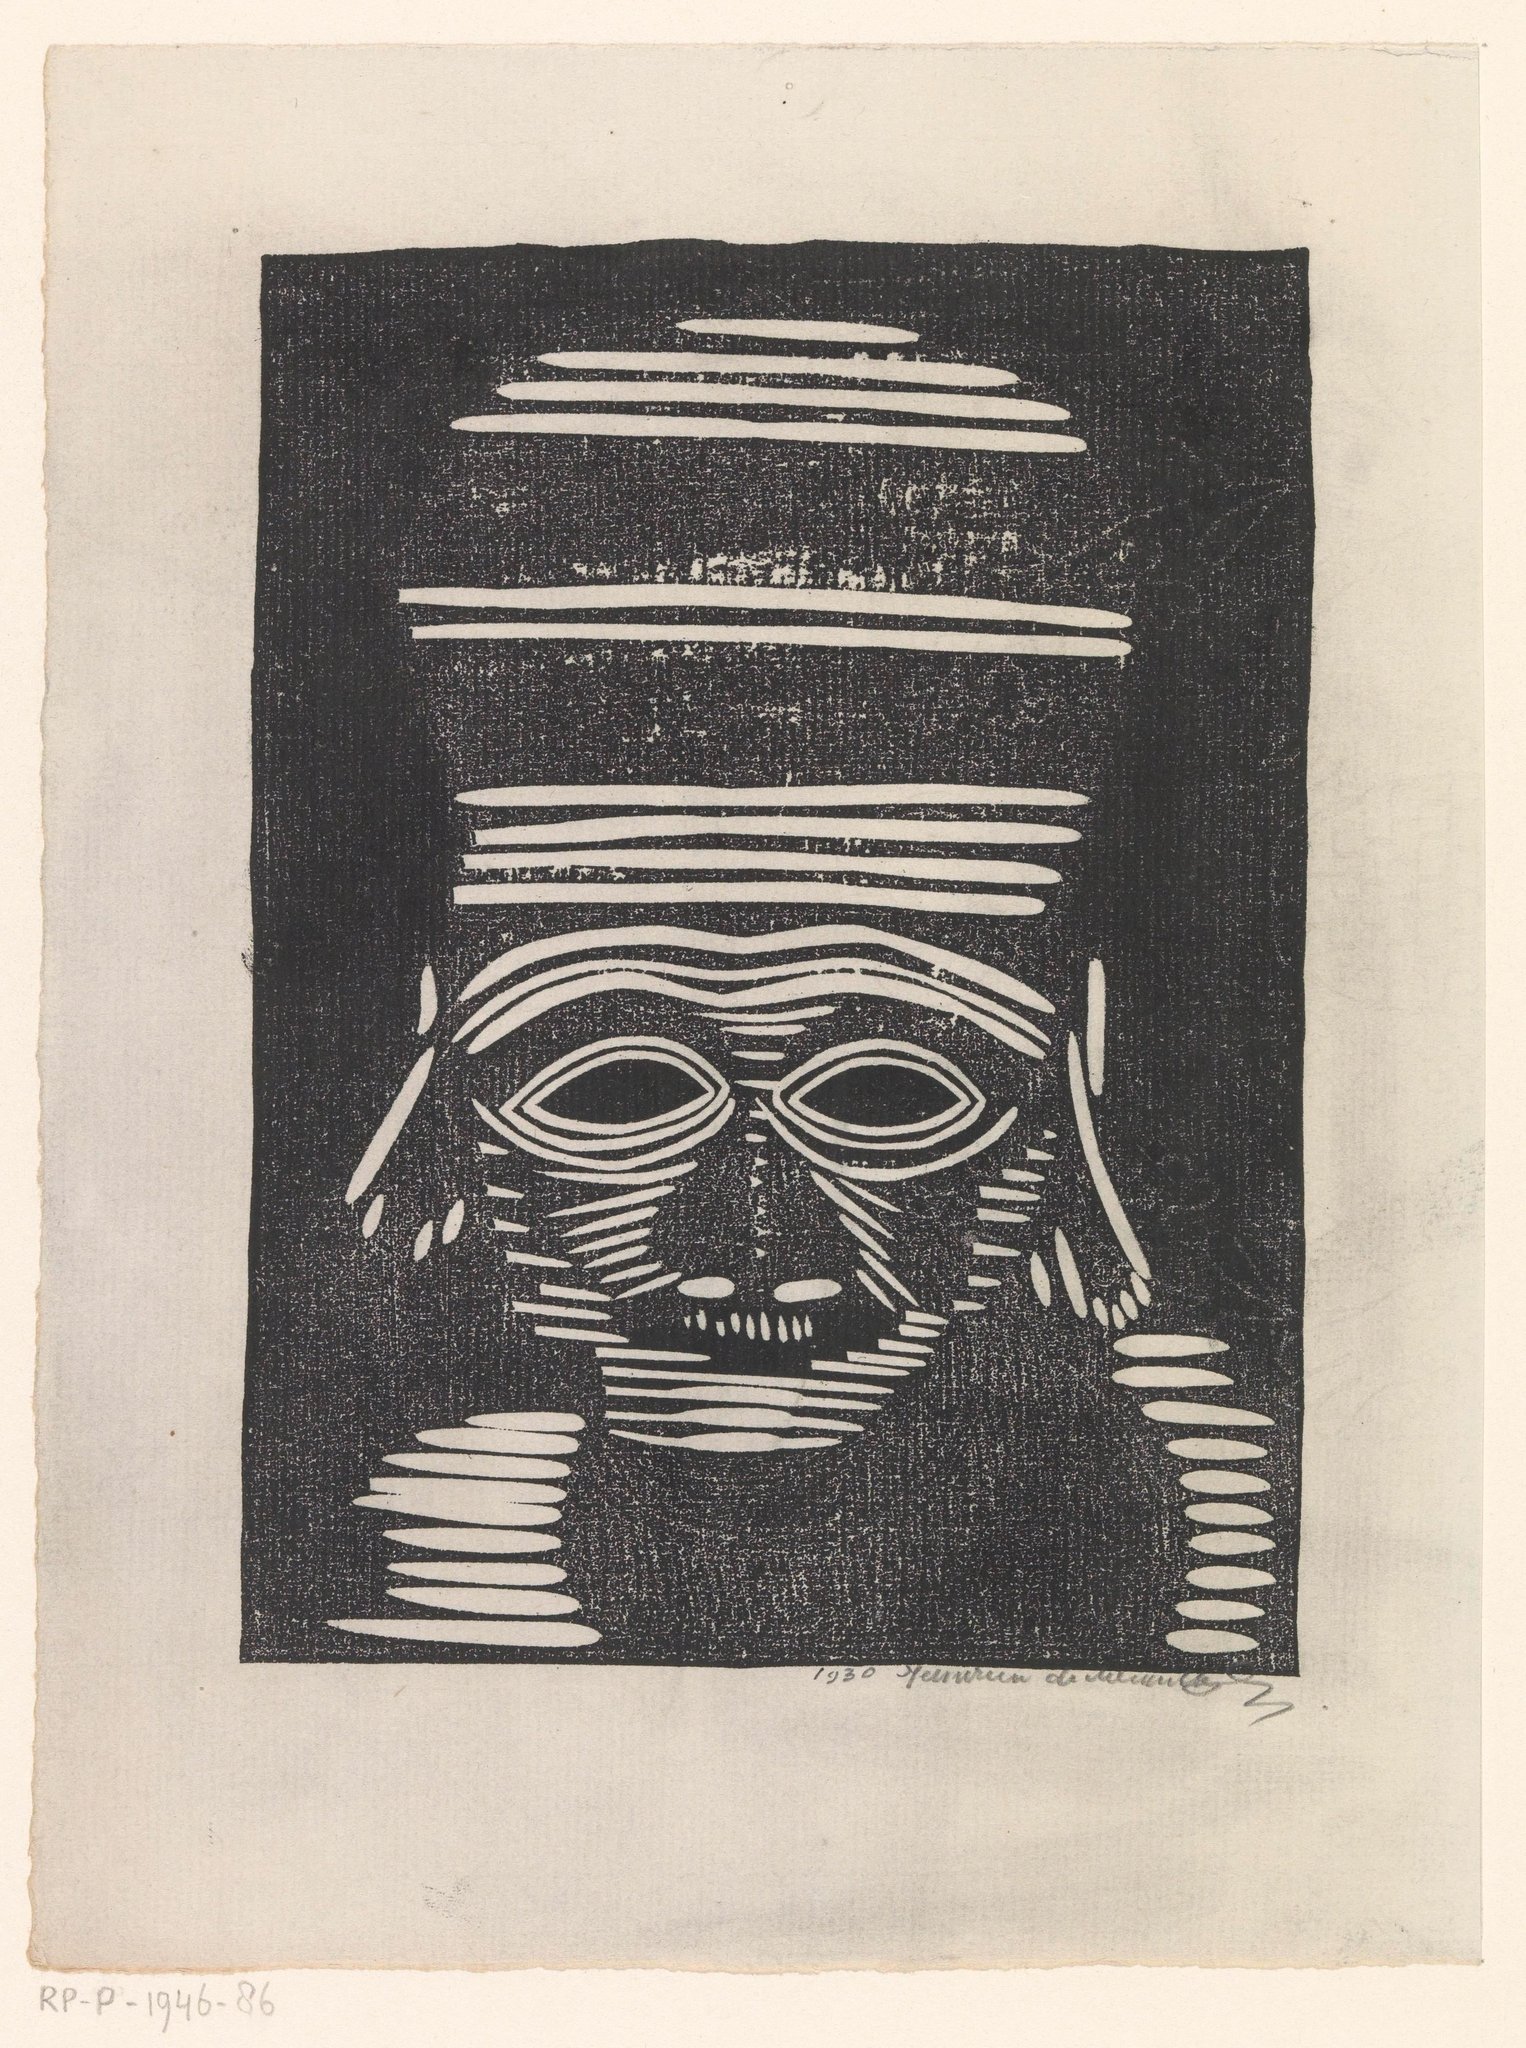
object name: print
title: Fantasie: kop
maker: samuel jessurun de mesquita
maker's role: draughtsman, print maker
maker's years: 1868-1944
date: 1930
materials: paper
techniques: woodcut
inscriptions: signature and date: ‘1930 Jessurun de mesquita’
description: Gezicht dat doet denken aan een etnisch masker, grotendeels opgebouwd uit horizontale witte banen.